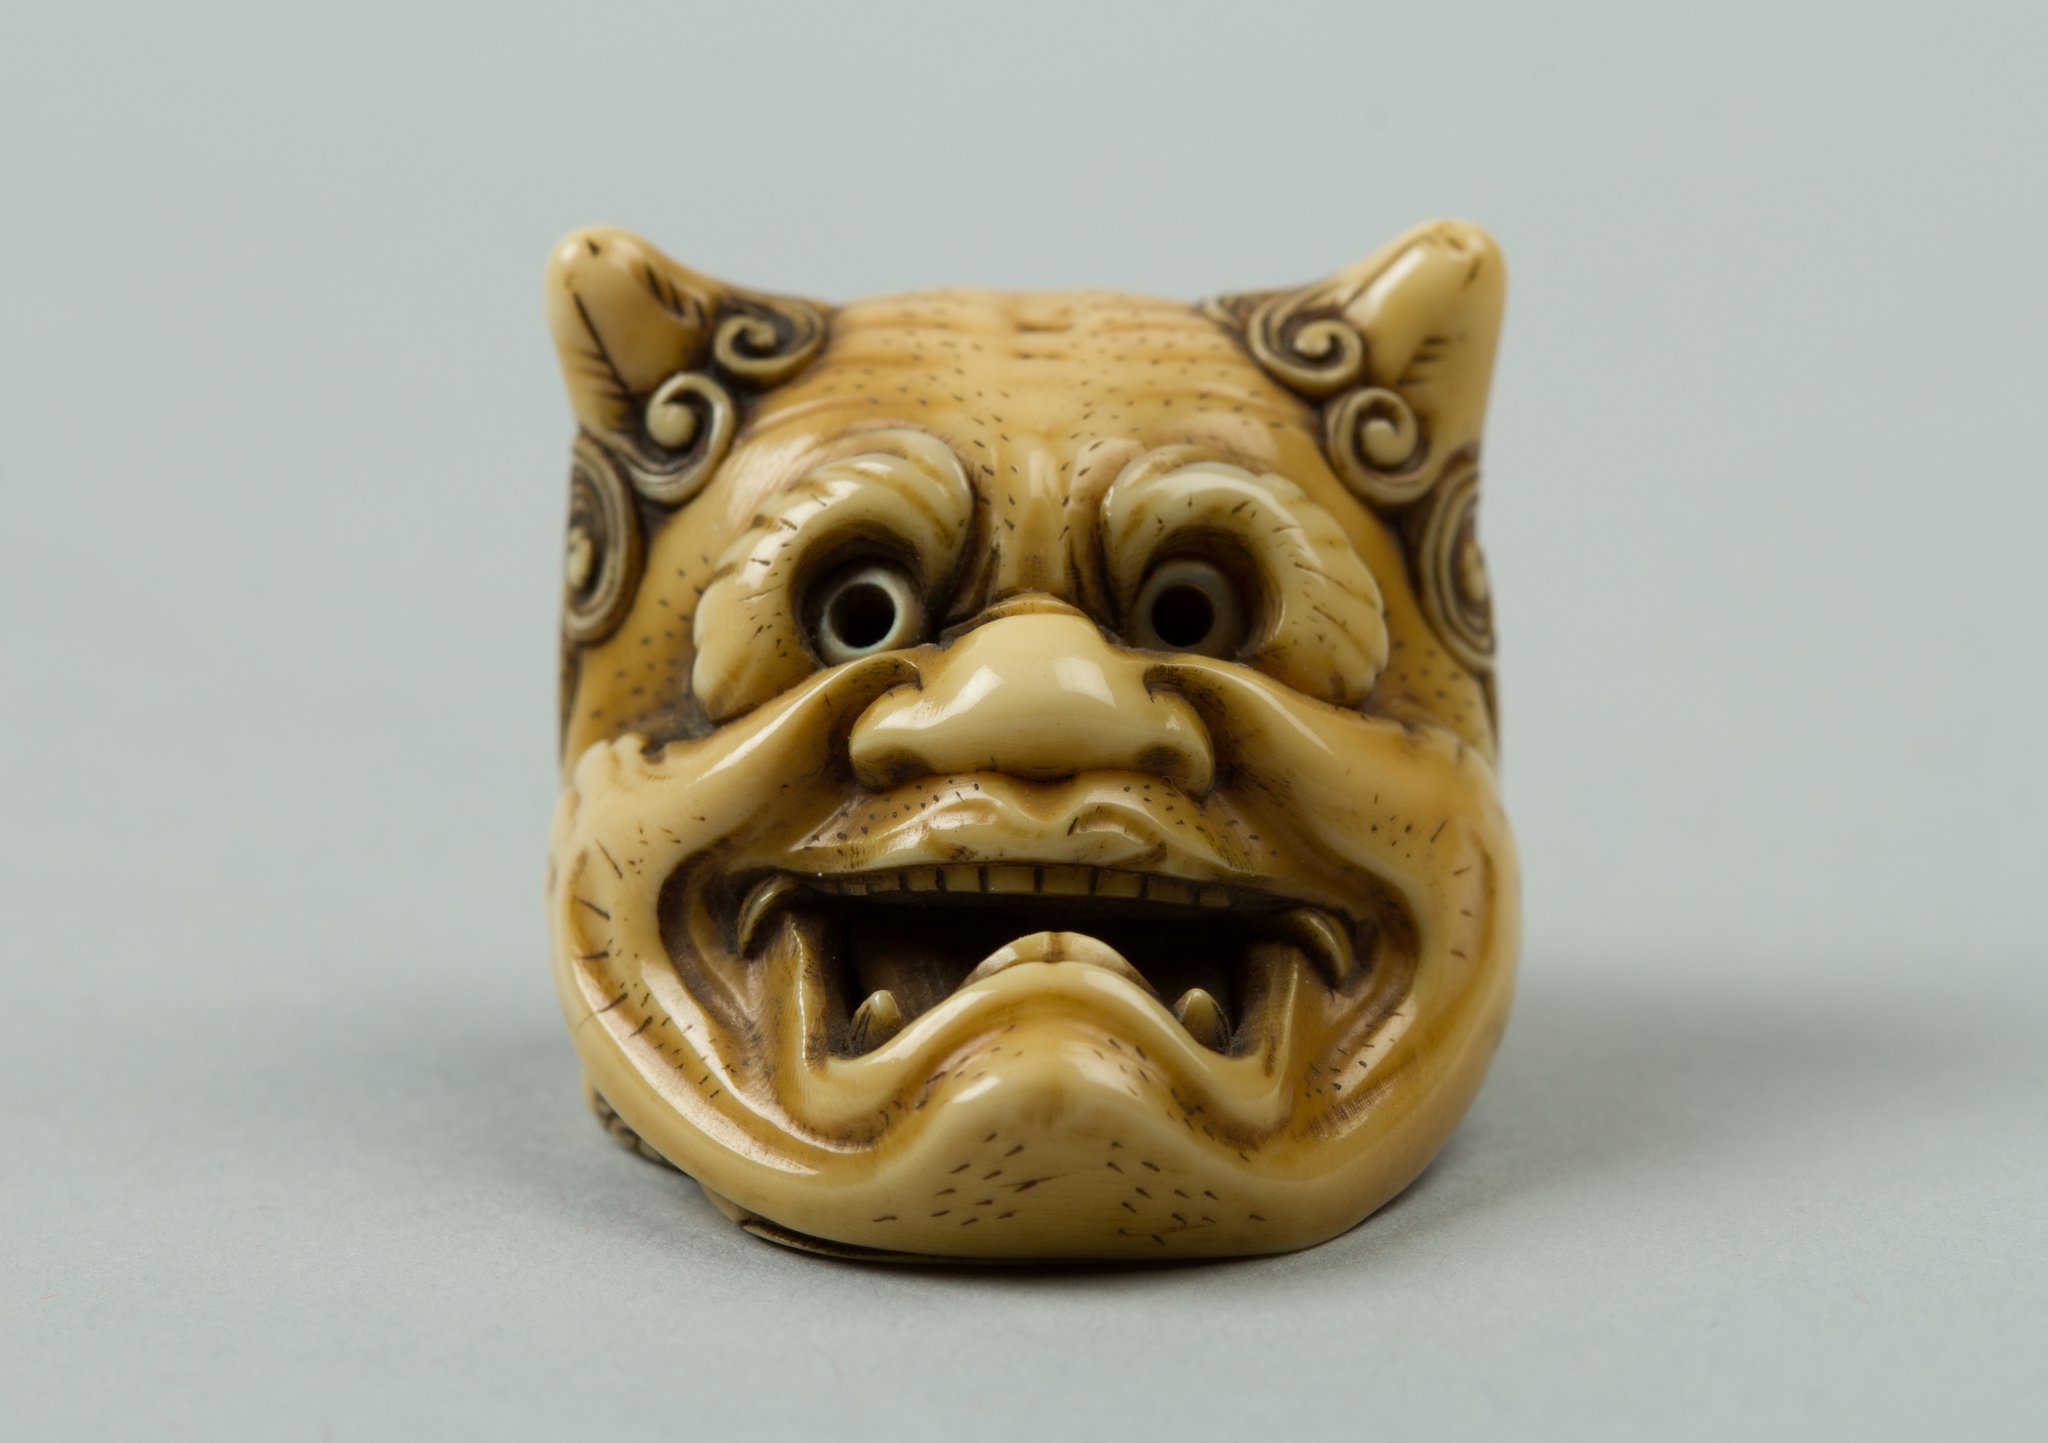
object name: netsuke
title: Netsuke of Okame under a Demon Mask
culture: japanese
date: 1801-1833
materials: ivory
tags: masks